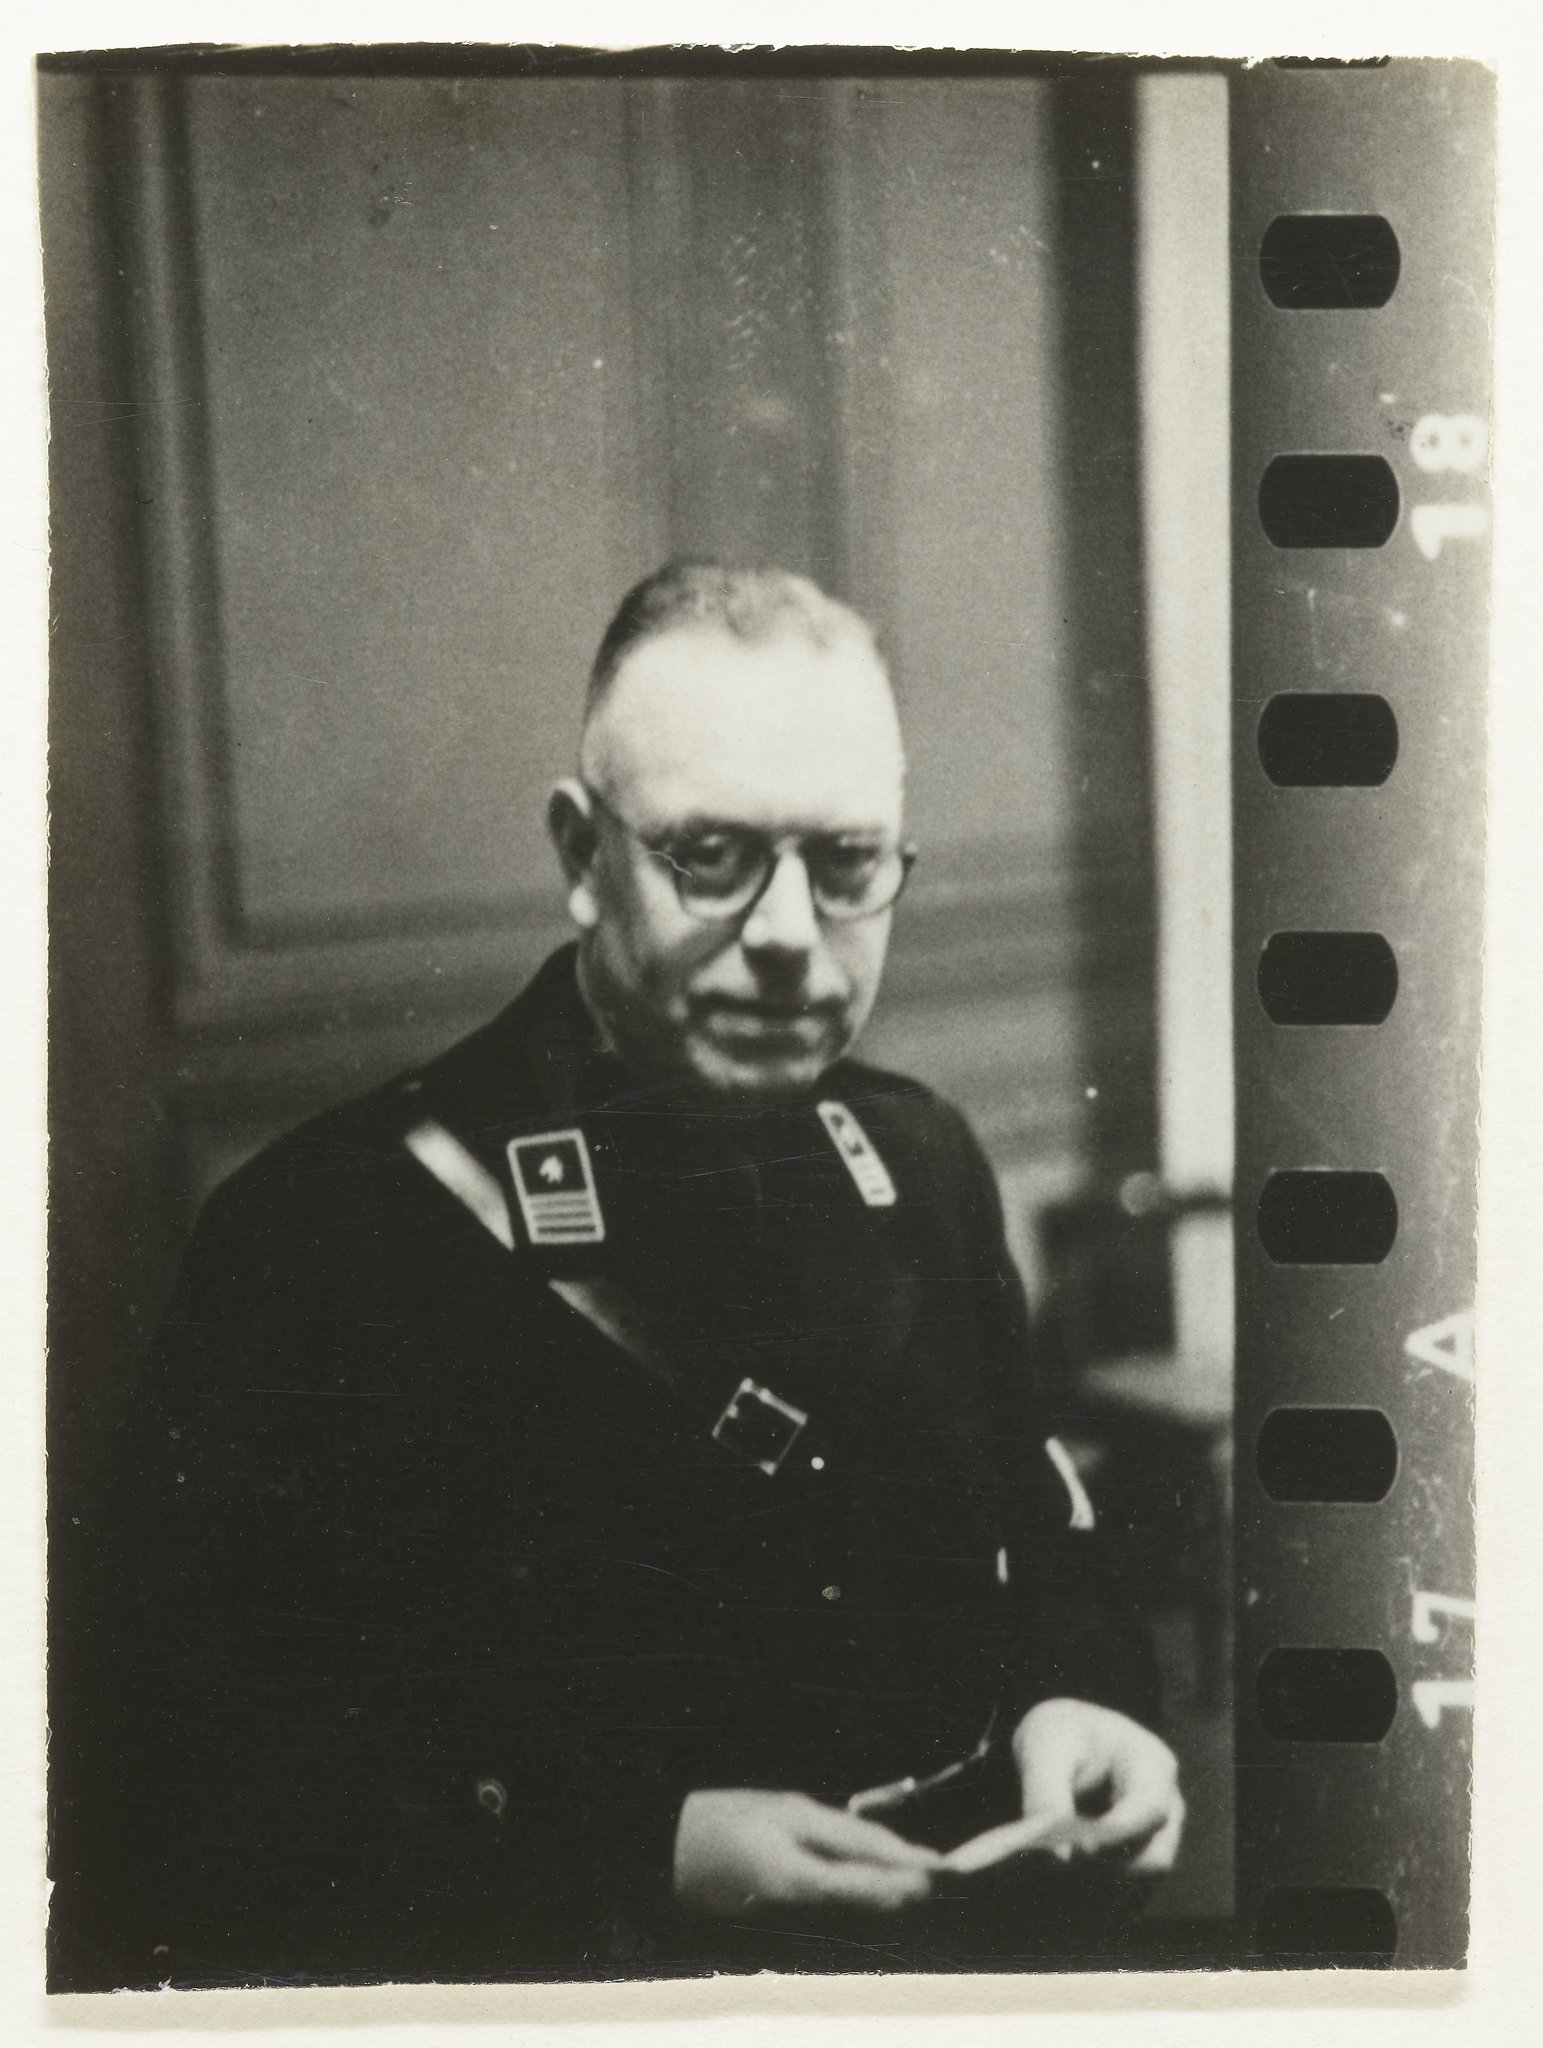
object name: contact print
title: NSB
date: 1940-1944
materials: photographic support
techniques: gelatin silver print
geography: netherlands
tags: anonymous historical person portrayed, netherlands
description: Portret van een lid van de NSB. Op zijn kraag een distinctief met met een ster en drie strepen eronder: Districtsbeheerder. Oudere man met bril, tot middel zichtbaar, ook zijn handen. Rand negatief zichtbaar.